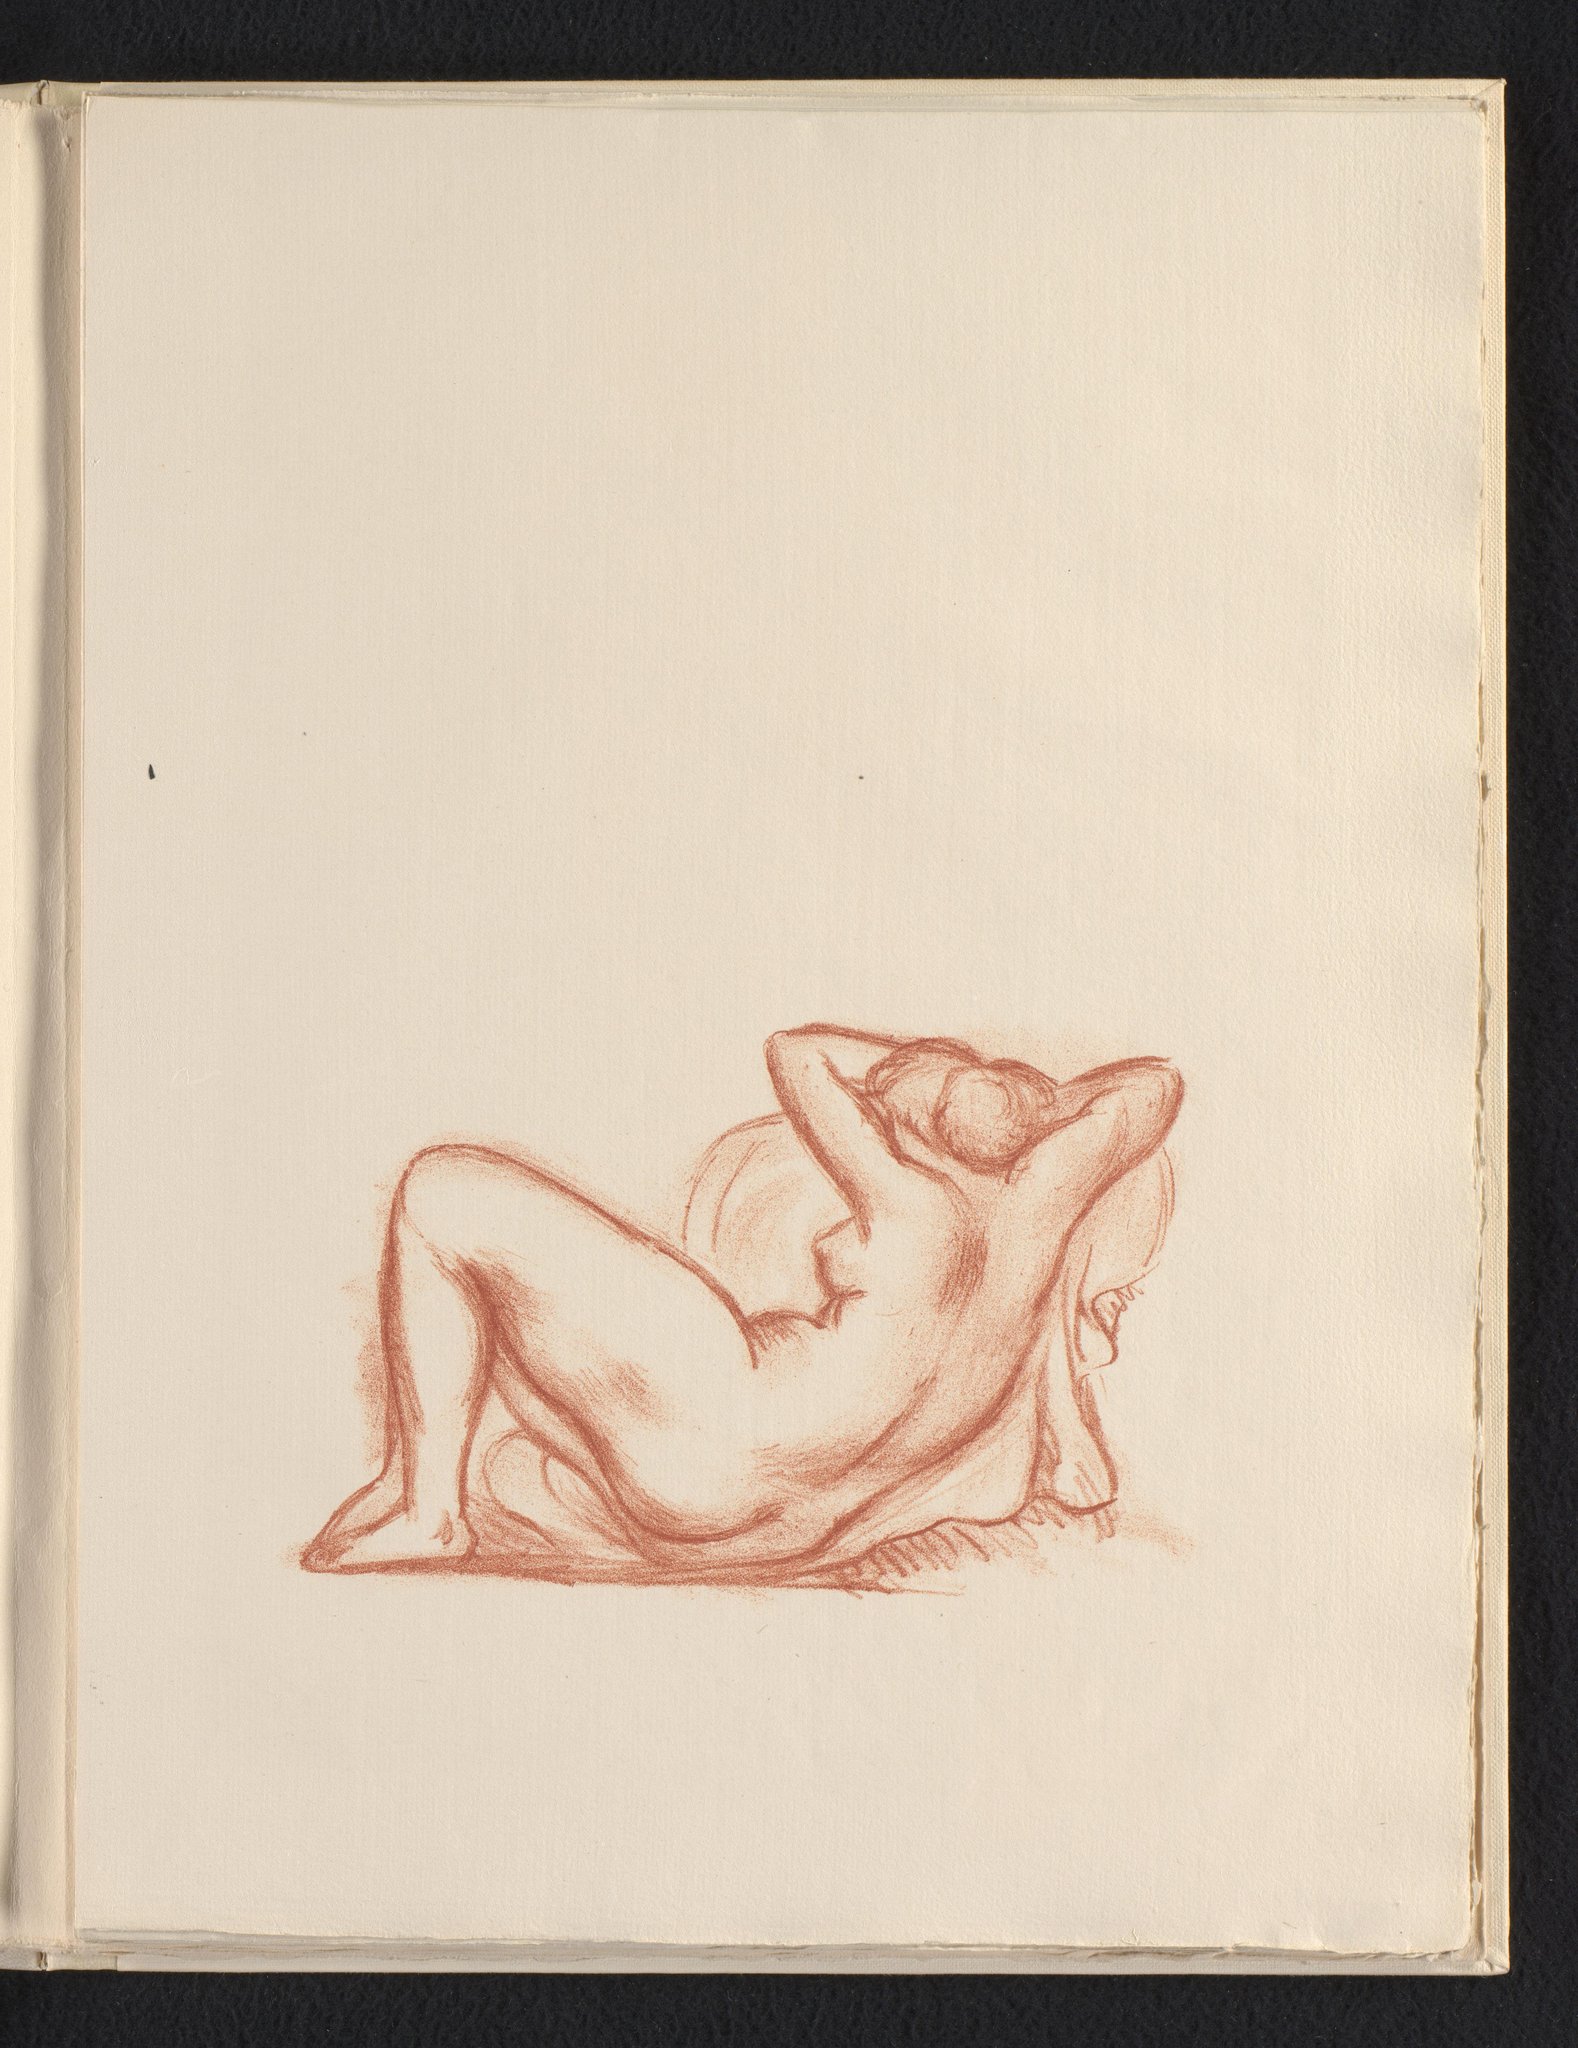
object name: page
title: Zittende naakte vrouw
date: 1948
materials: paper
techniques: lithograph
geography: paris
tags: sitting figure - aa - female human figure, woman (showing herself) undressed, quasi-nude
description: Prent uit: Lucianus van Samosata. Dialogues des Courtisanes. [Vertaald uit het Grieks door] Charles Astruc. Parijs: s.n., 1948, deel van de suite met een extra afdruk van de prenten in sanguine.